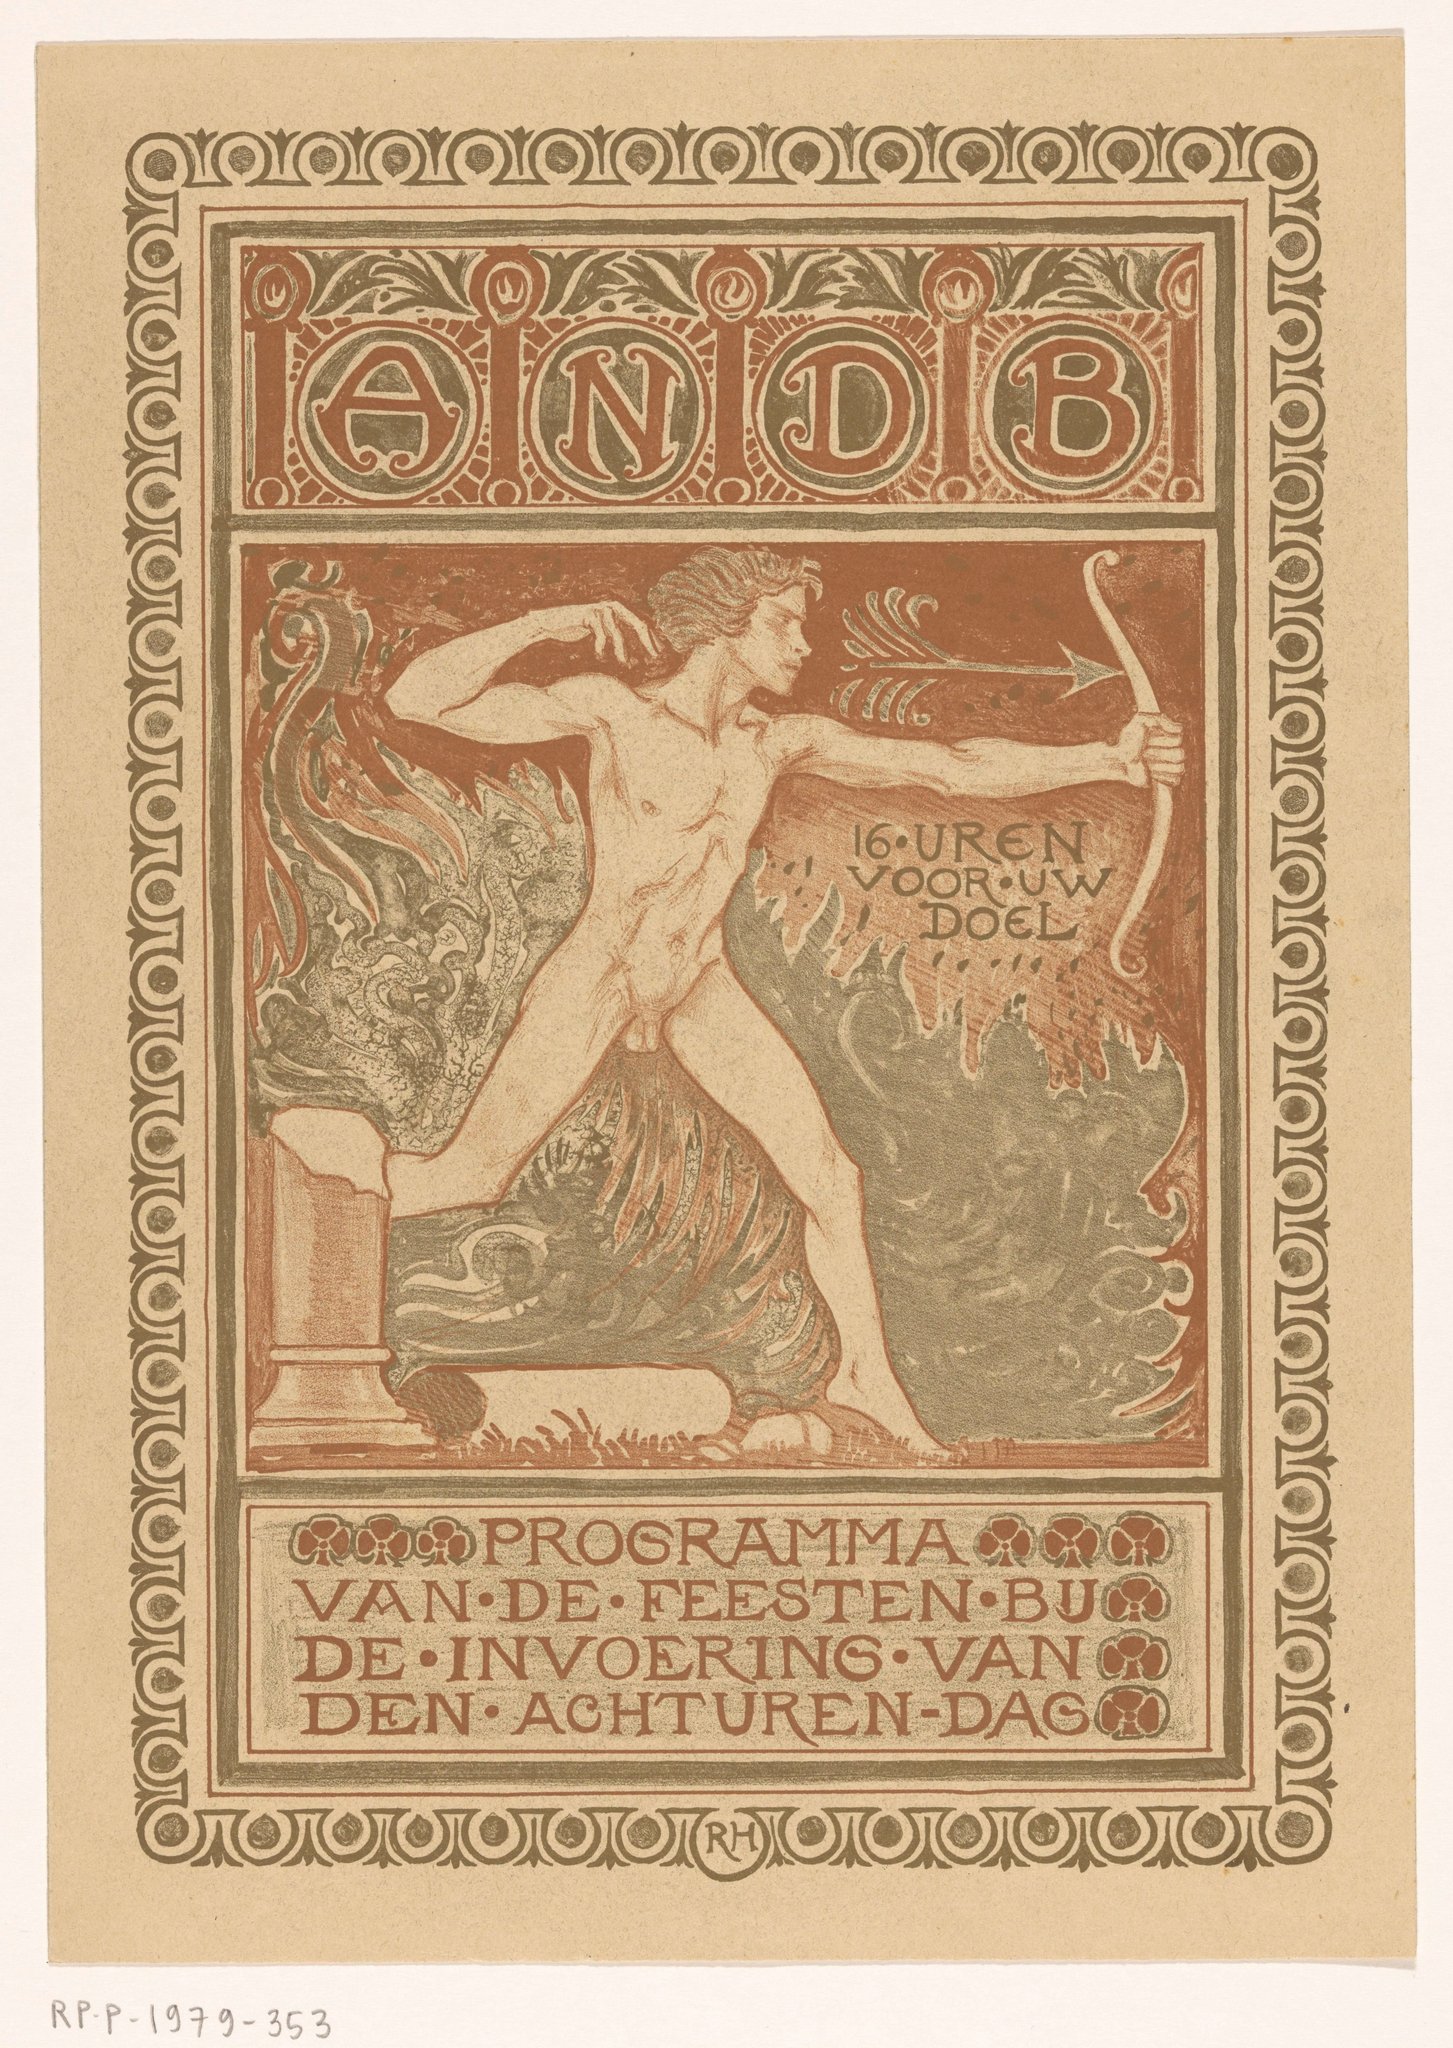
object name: design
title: Omslagontwerp voor: Feestprogramma van de Algemene Nederlandse Diamantbewerkersbond bij de invoering van de achturendag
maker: richard nicolaüs roland holst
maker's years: 1868-1938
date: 1911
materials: paper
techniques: lithograph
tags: archer's weapons: bow and arrow, column, pillar ~ architecture, man (showing himself) undressed, quasi-nude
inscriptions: collector's mark: Lugt 2228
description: Een rechthoekig kader met daarin een naakte man die met een boog een pijl afschiet. Onder zijn gestrekte arm de tekst '16 uren voor uw doel'. Bij zijn benen een gebroken zuil.